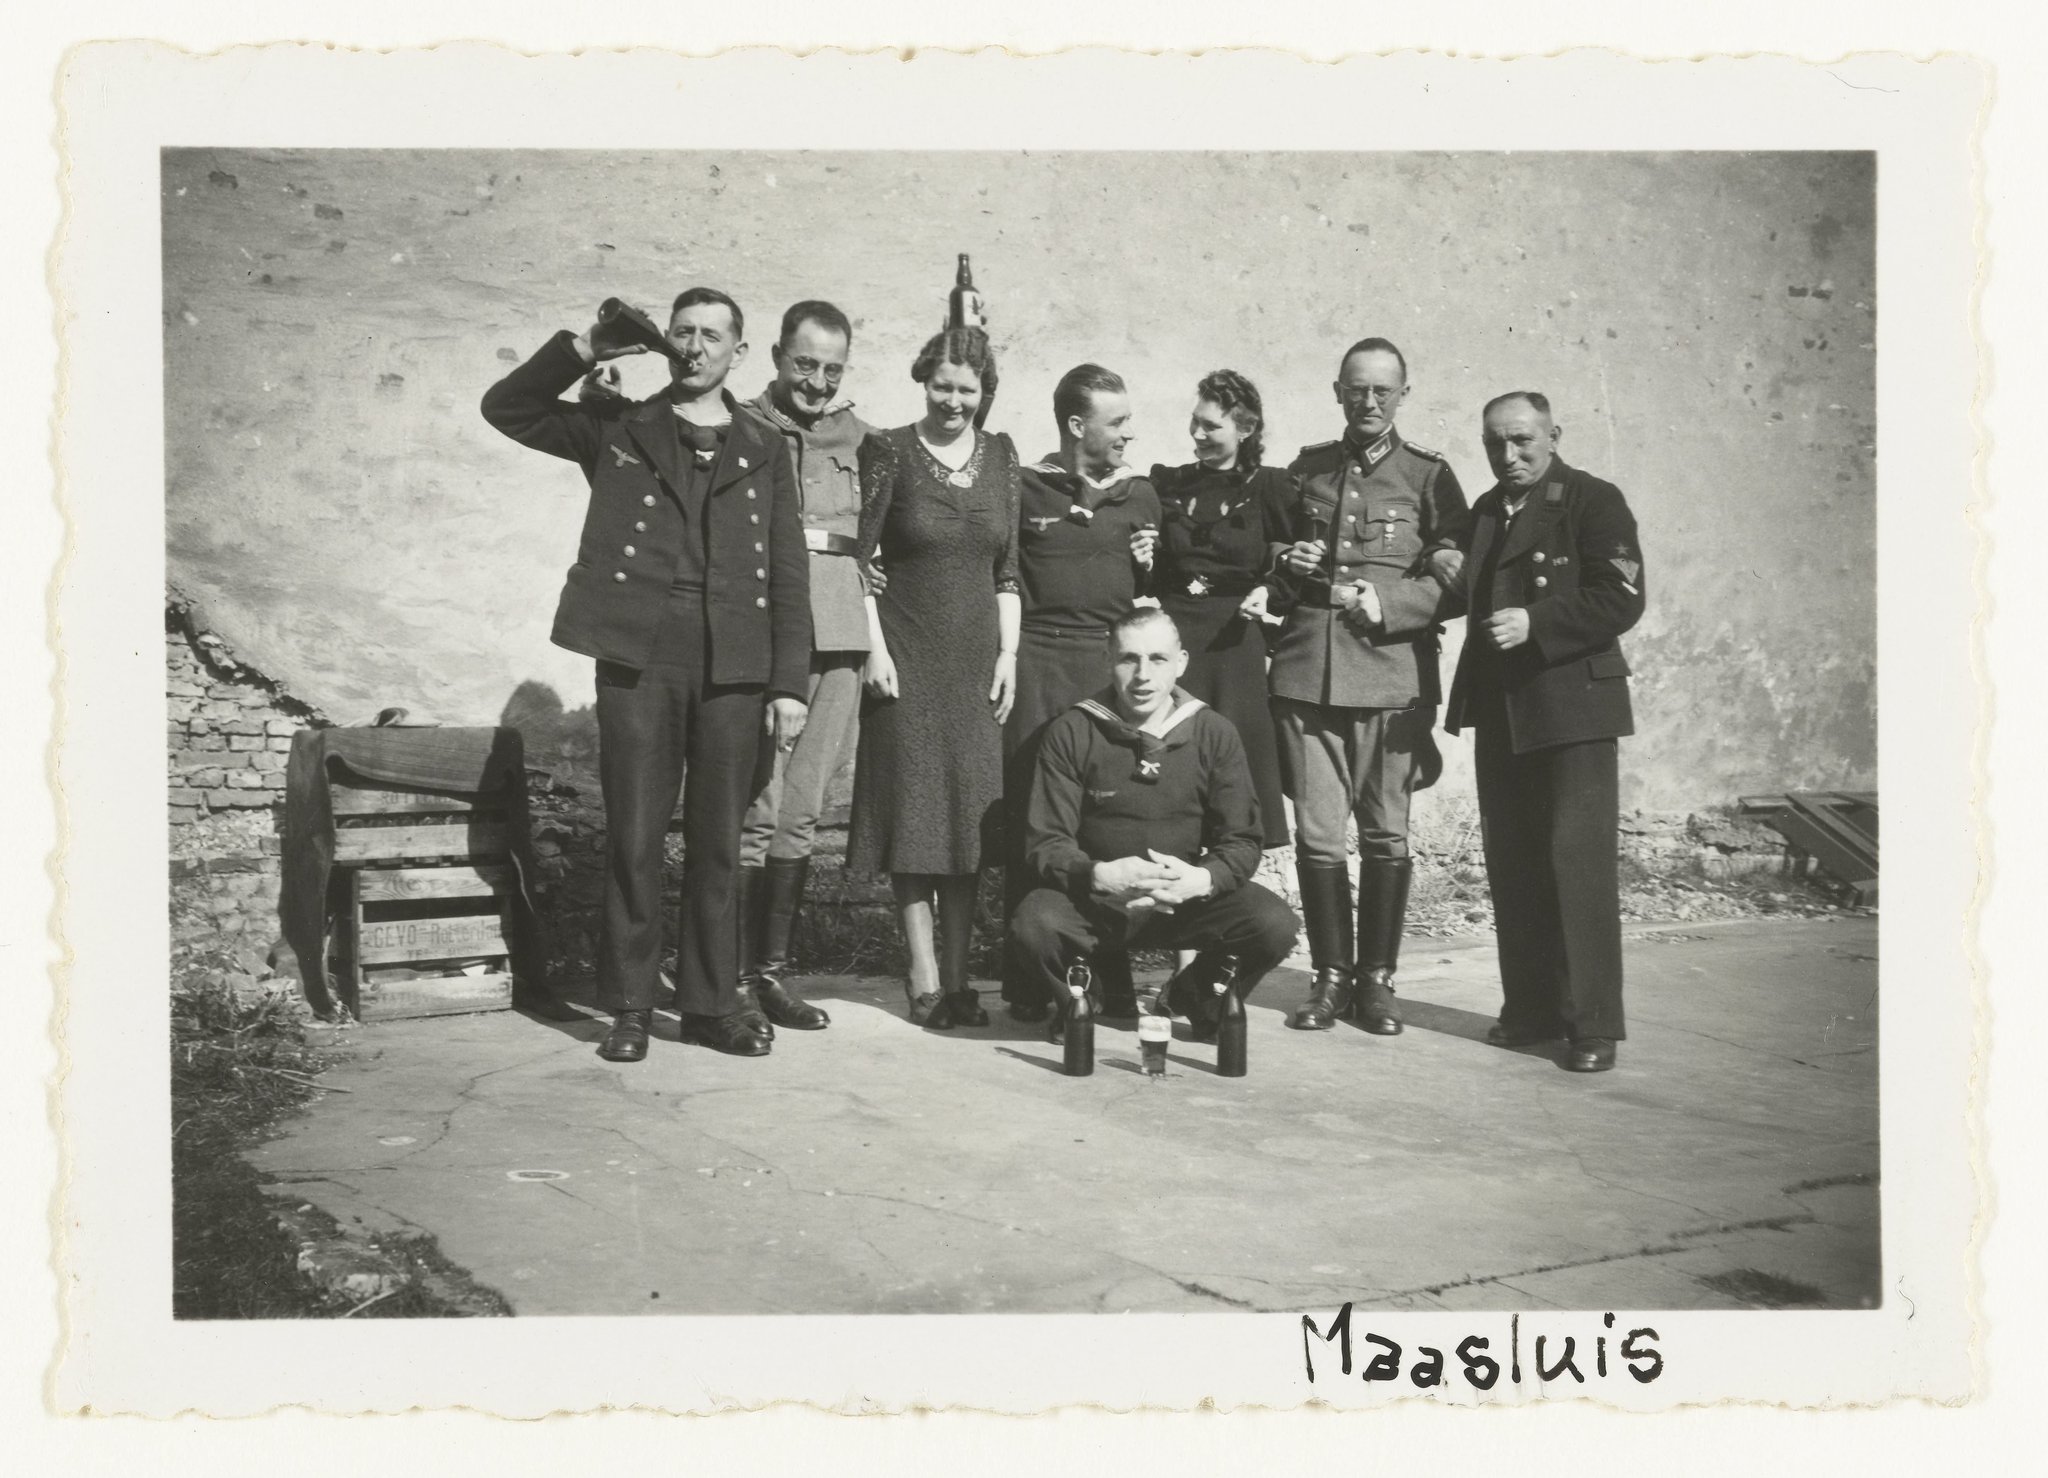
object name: photograph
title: Wehrmacht- en Kriegsmarine soldaten met Nederlandse meisjes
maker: Anonymous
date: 1941-1942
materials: photographic support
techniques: gelatin silver print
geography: maassluis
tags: occupier and civilians, occupation ~ war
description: Twee Wehrmacht militairen en vier van de Kriegsmarine staan buiten met twee Nederlandse meisjes. Een soldaat van de Kriegsmarine drinkt uit een fles, een ander houdt een fles boven het hoofd van een Nederlands meisje. Op de grond staan nog twee flesjes en een glas bier. Onderop de foto staat Maassluis, op de achterkant: Kameradschaftsfest den Brielle